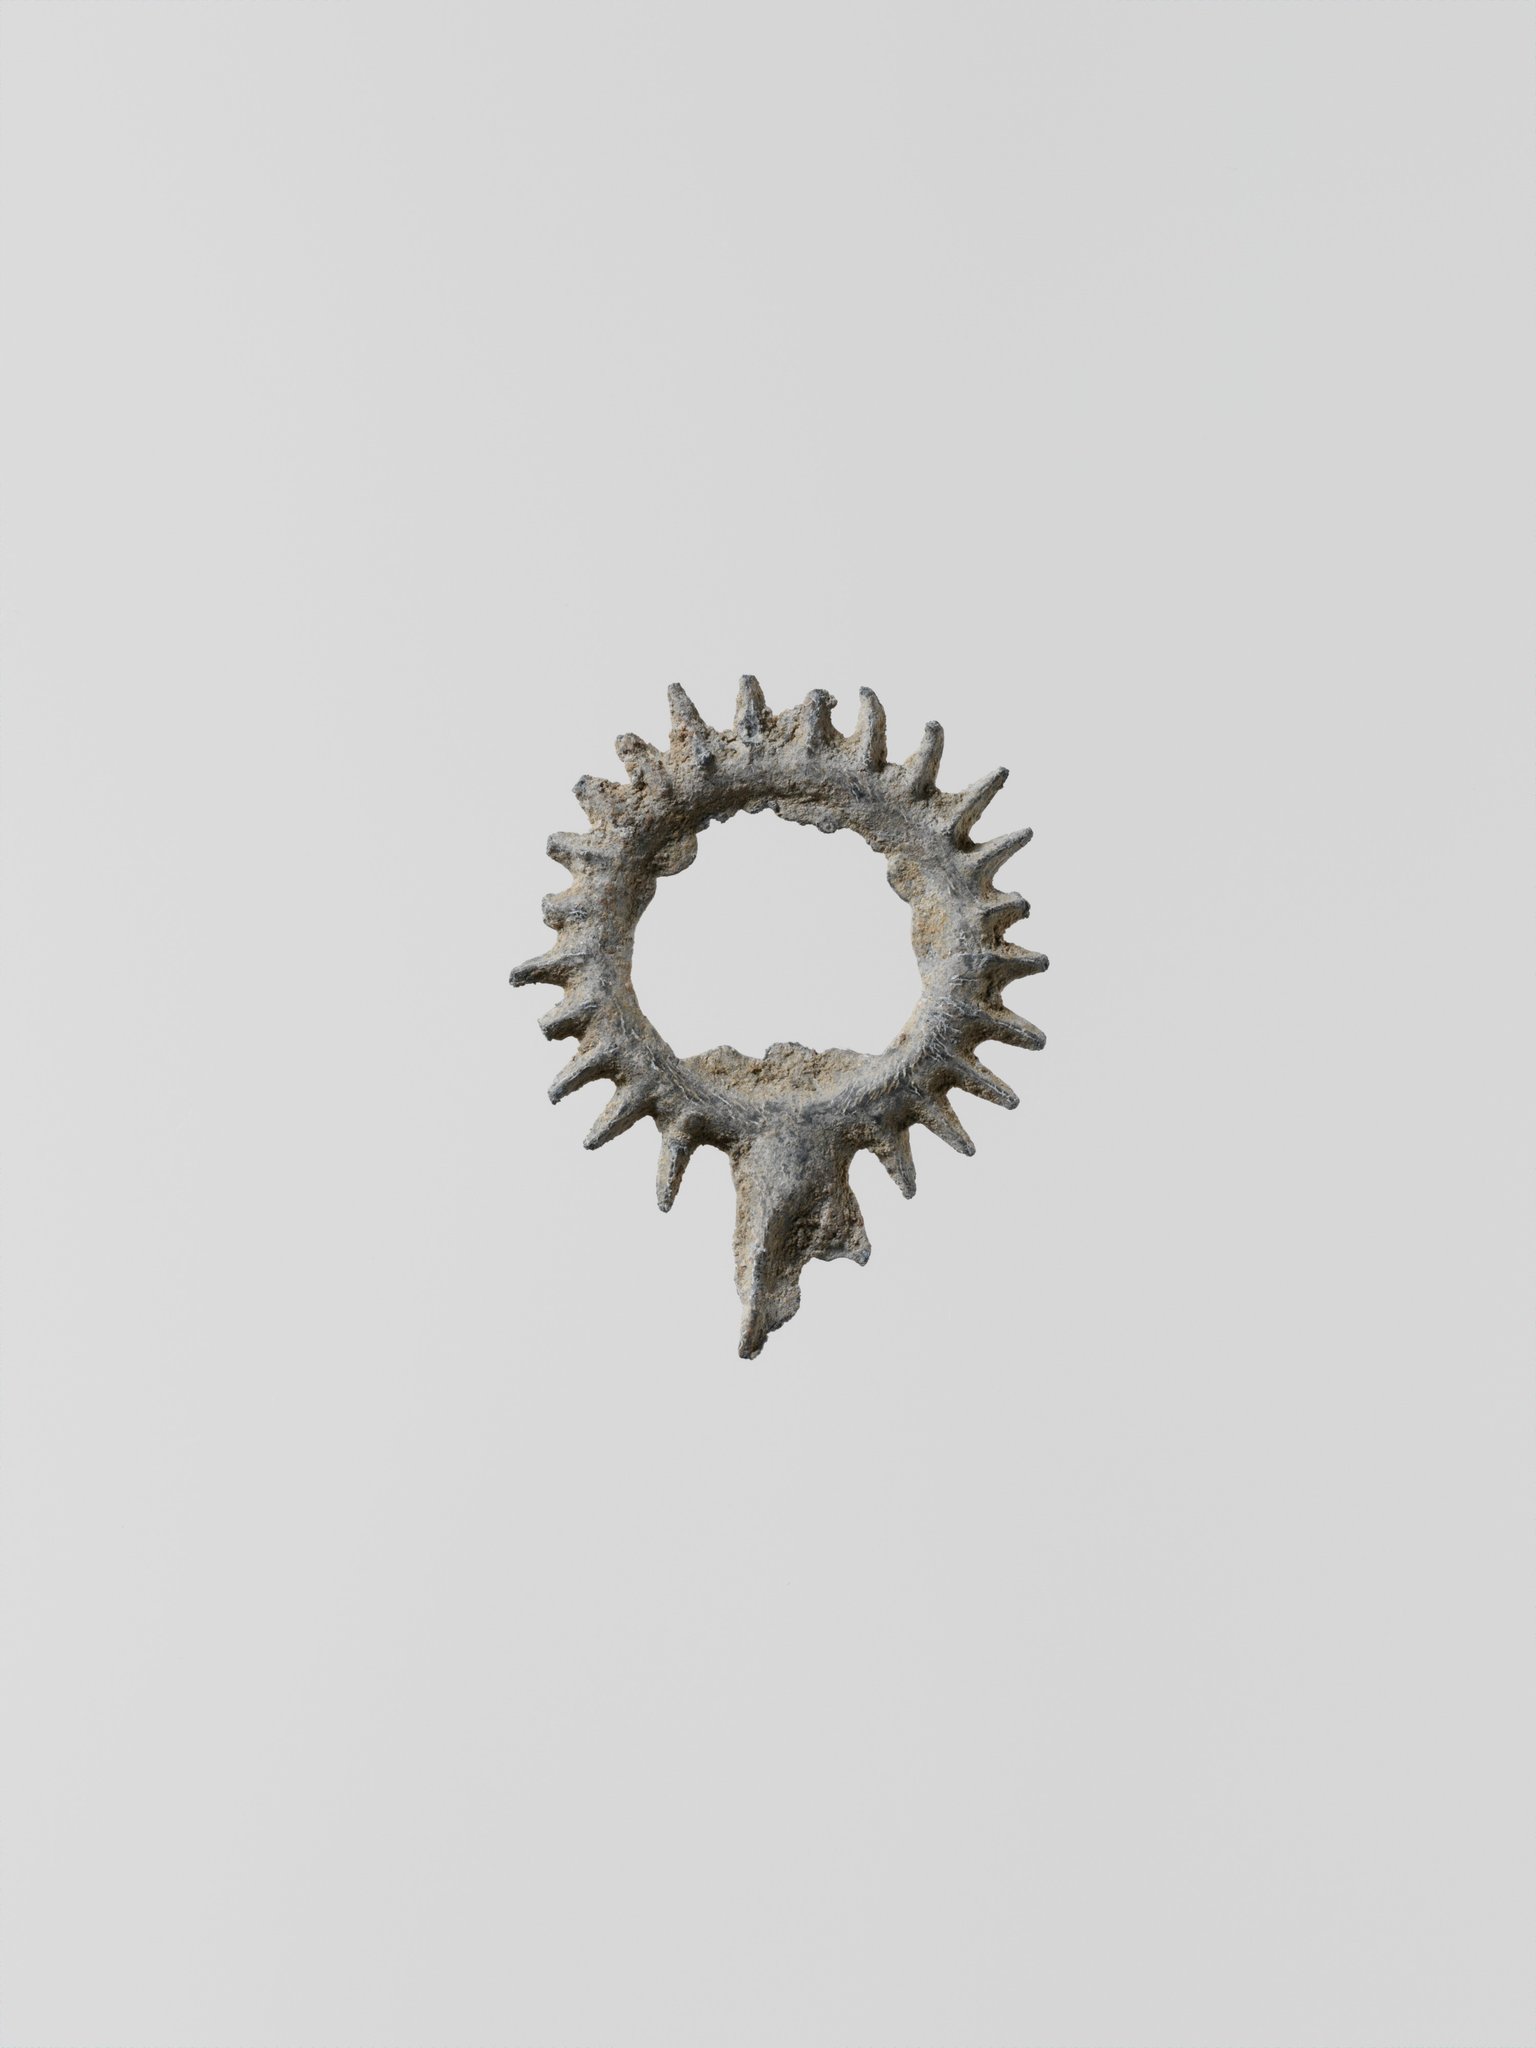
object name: wreath, 11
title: Lead wreath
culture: greek, laconian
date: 600-401 BCE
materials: lead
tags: wreaths